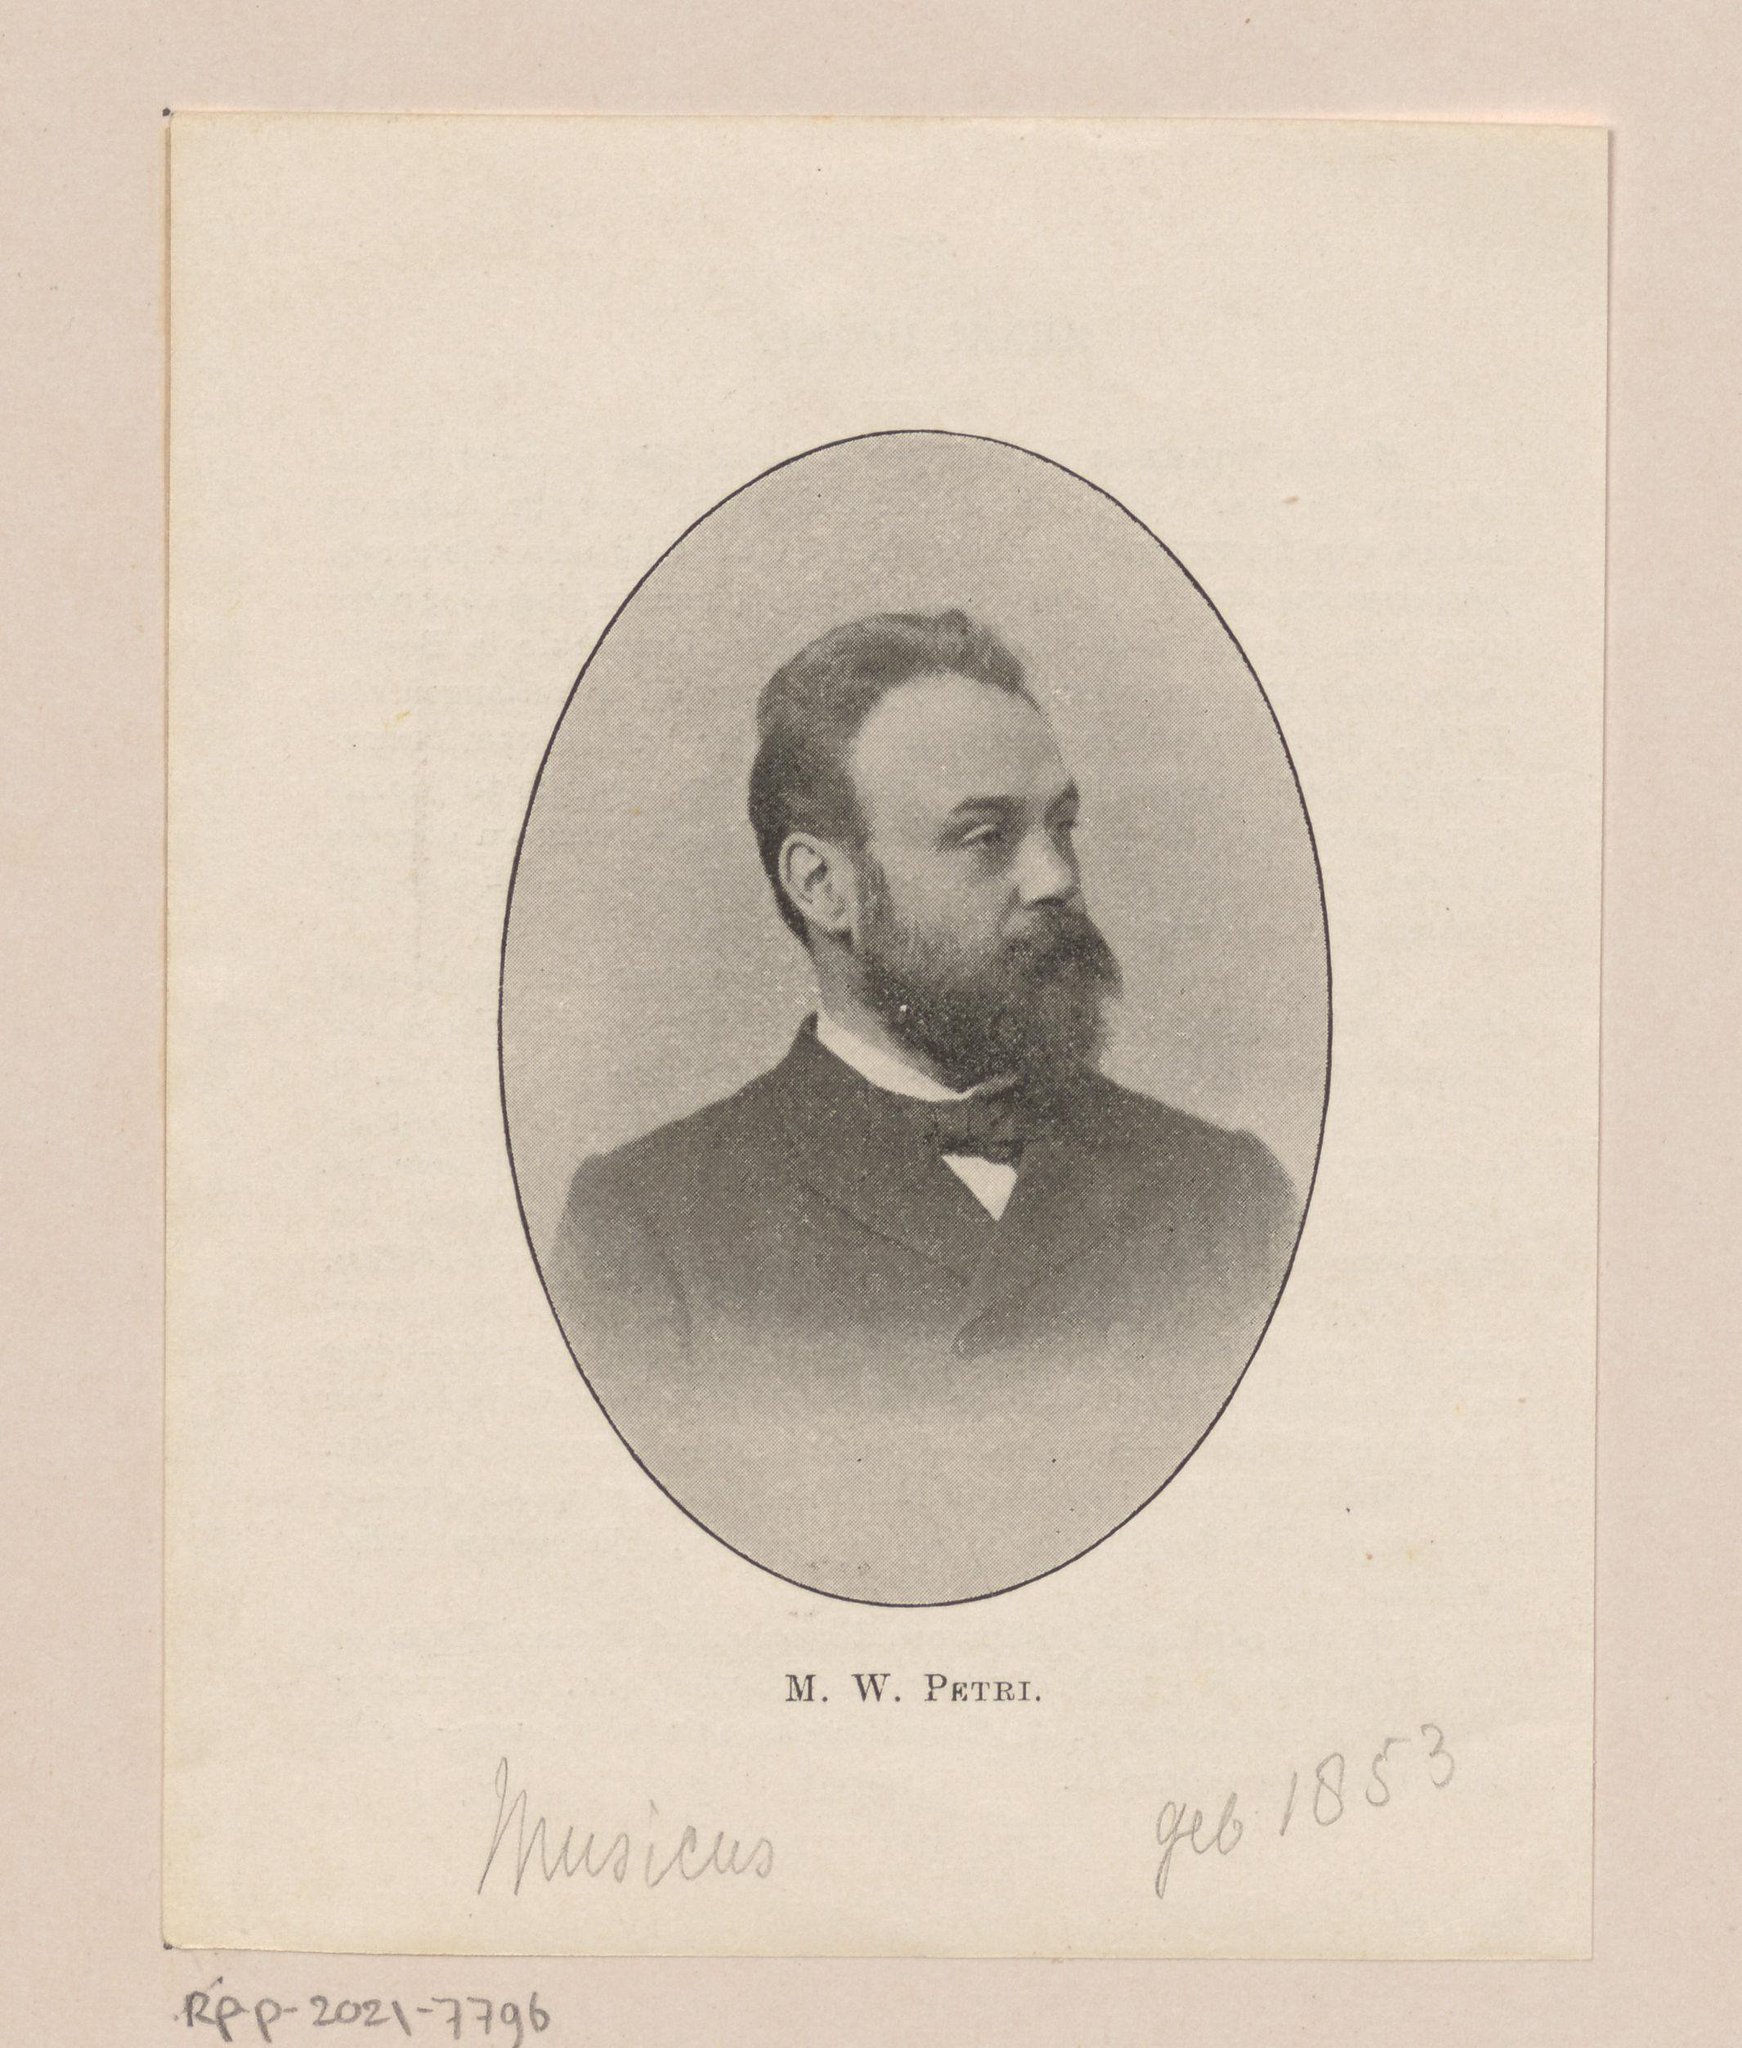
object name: photomechanical print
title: Portret van Martinus Wilhelm Petri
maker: Anonymous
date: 1898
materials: paper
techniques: letterpress printing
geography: rotterdam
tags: utrecht, adult man, historical persons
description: Prent uit: Onze musici: portretten en biografieën. Rotterdam: Nijgh en Van Ditmar, 1898.